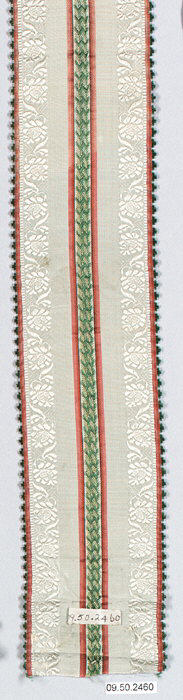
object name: ribbon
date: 1701-1800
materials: silk